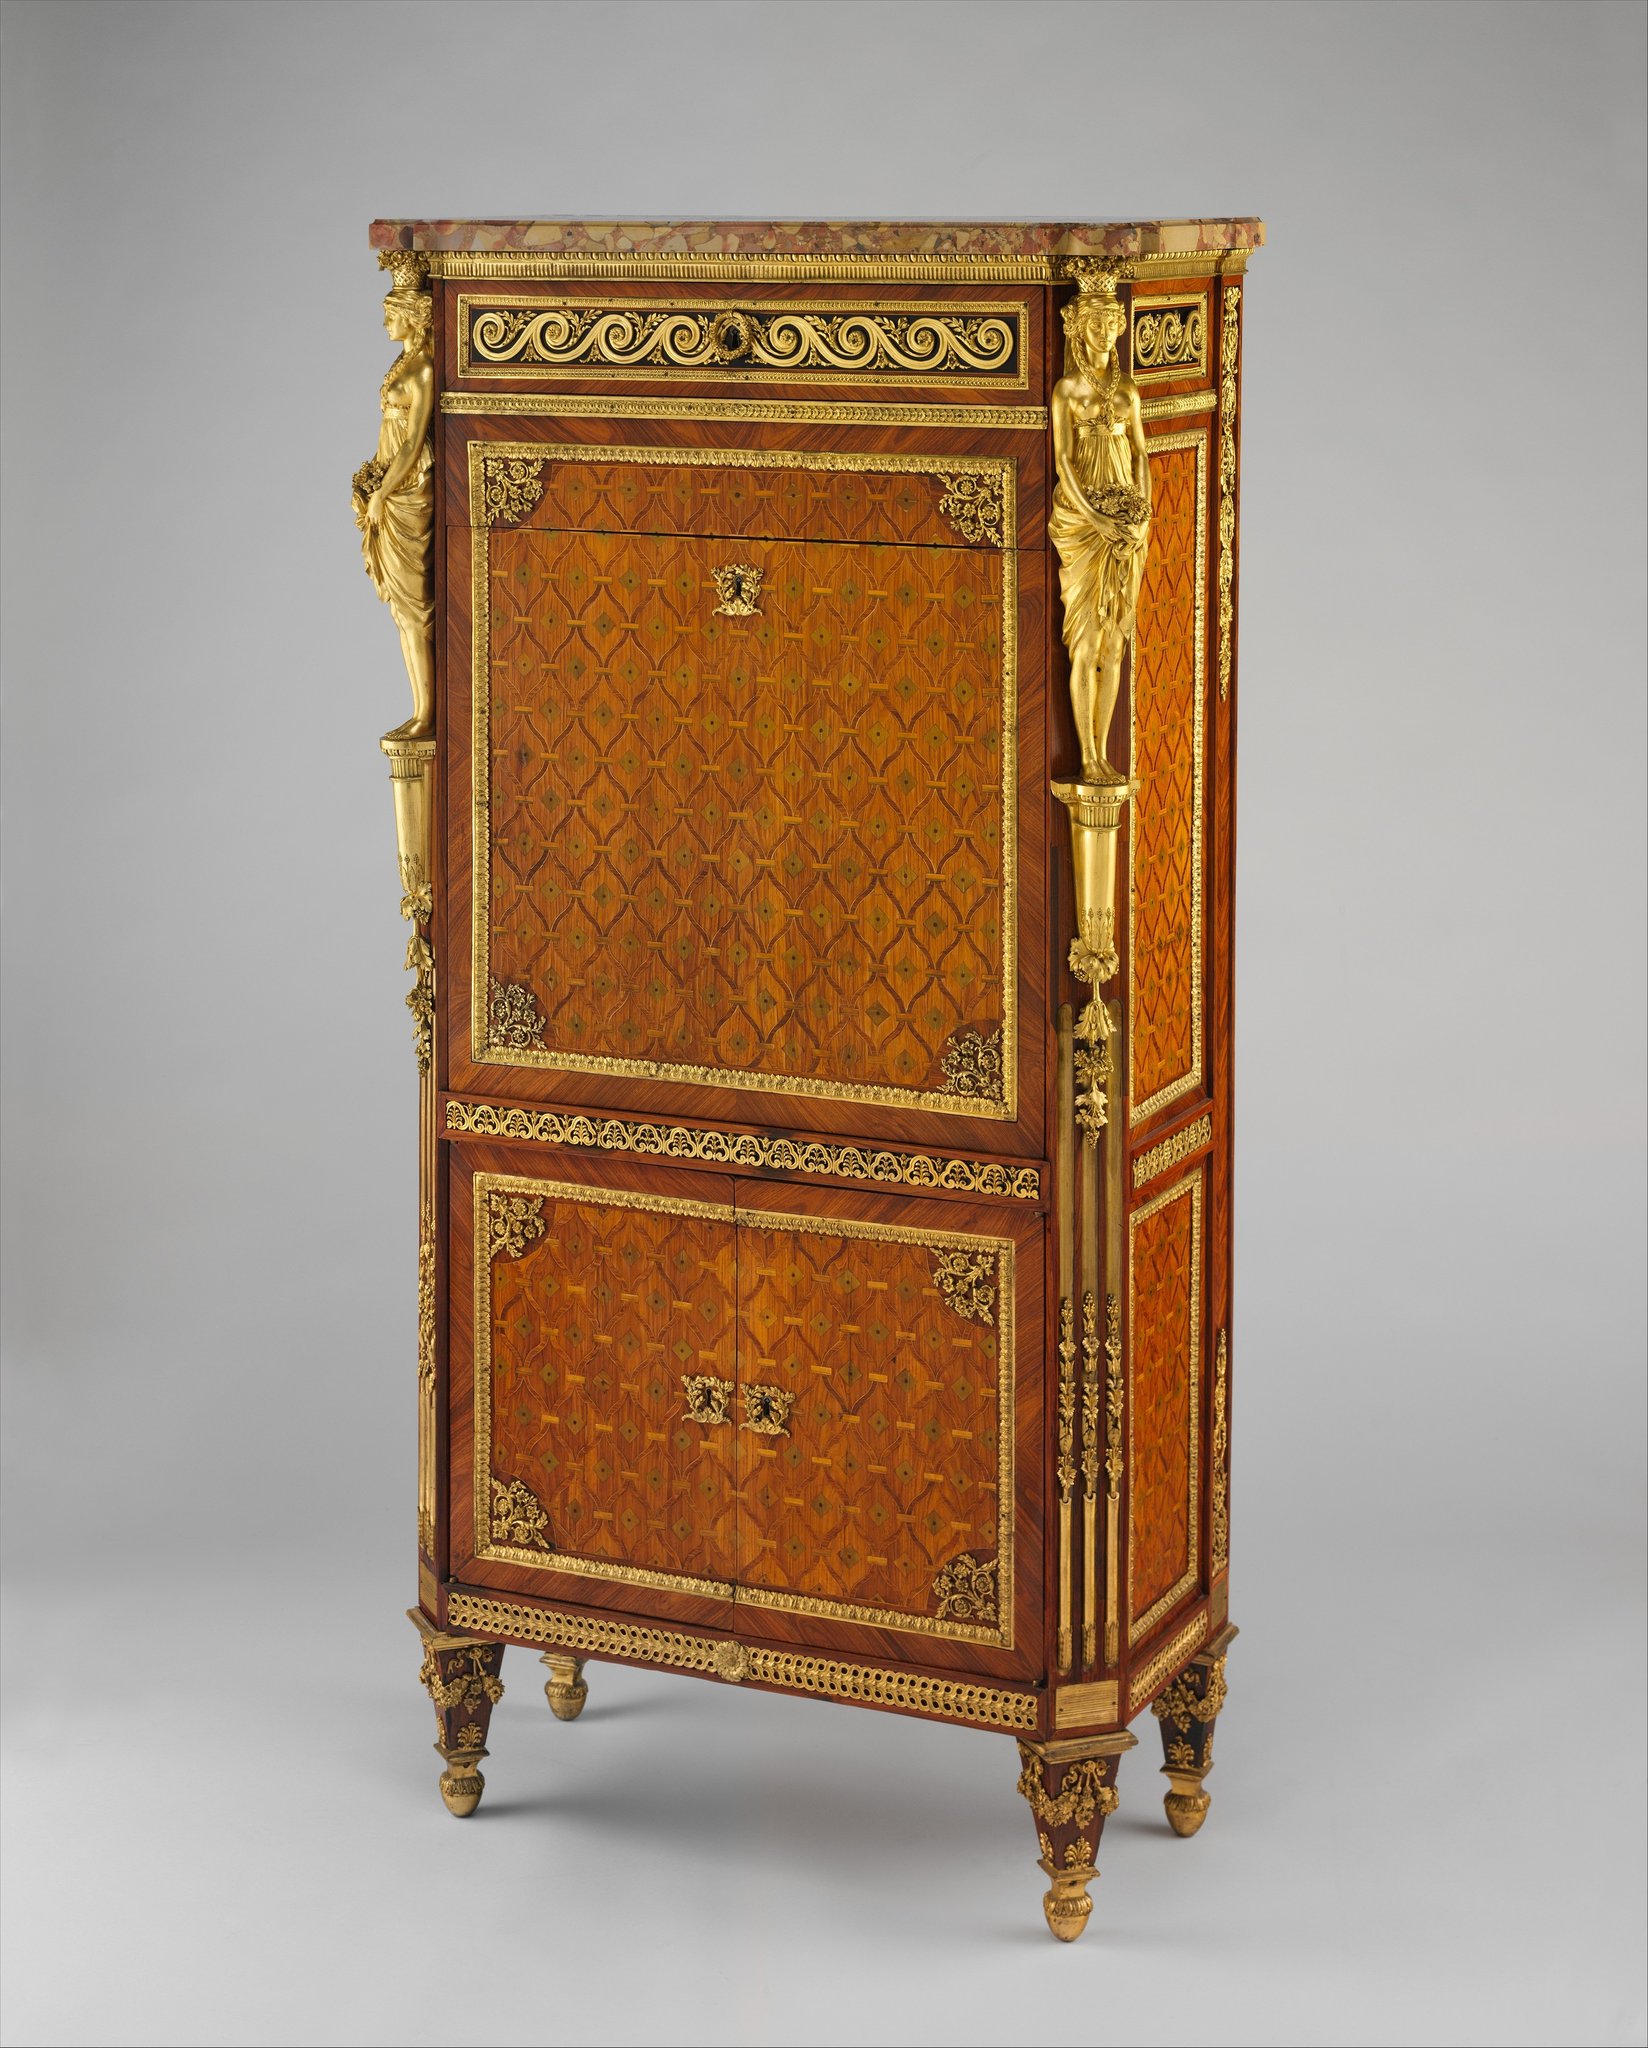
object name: drop front secretary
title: Drop-front secretary (secrétaire à abattant or secrétaire en armoire)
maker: guillaume benneman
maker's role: maker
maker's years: 1711-1811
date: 1786-1787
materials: wood, gilt bronze, leather, marble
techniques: stain, veneering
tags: caryatids